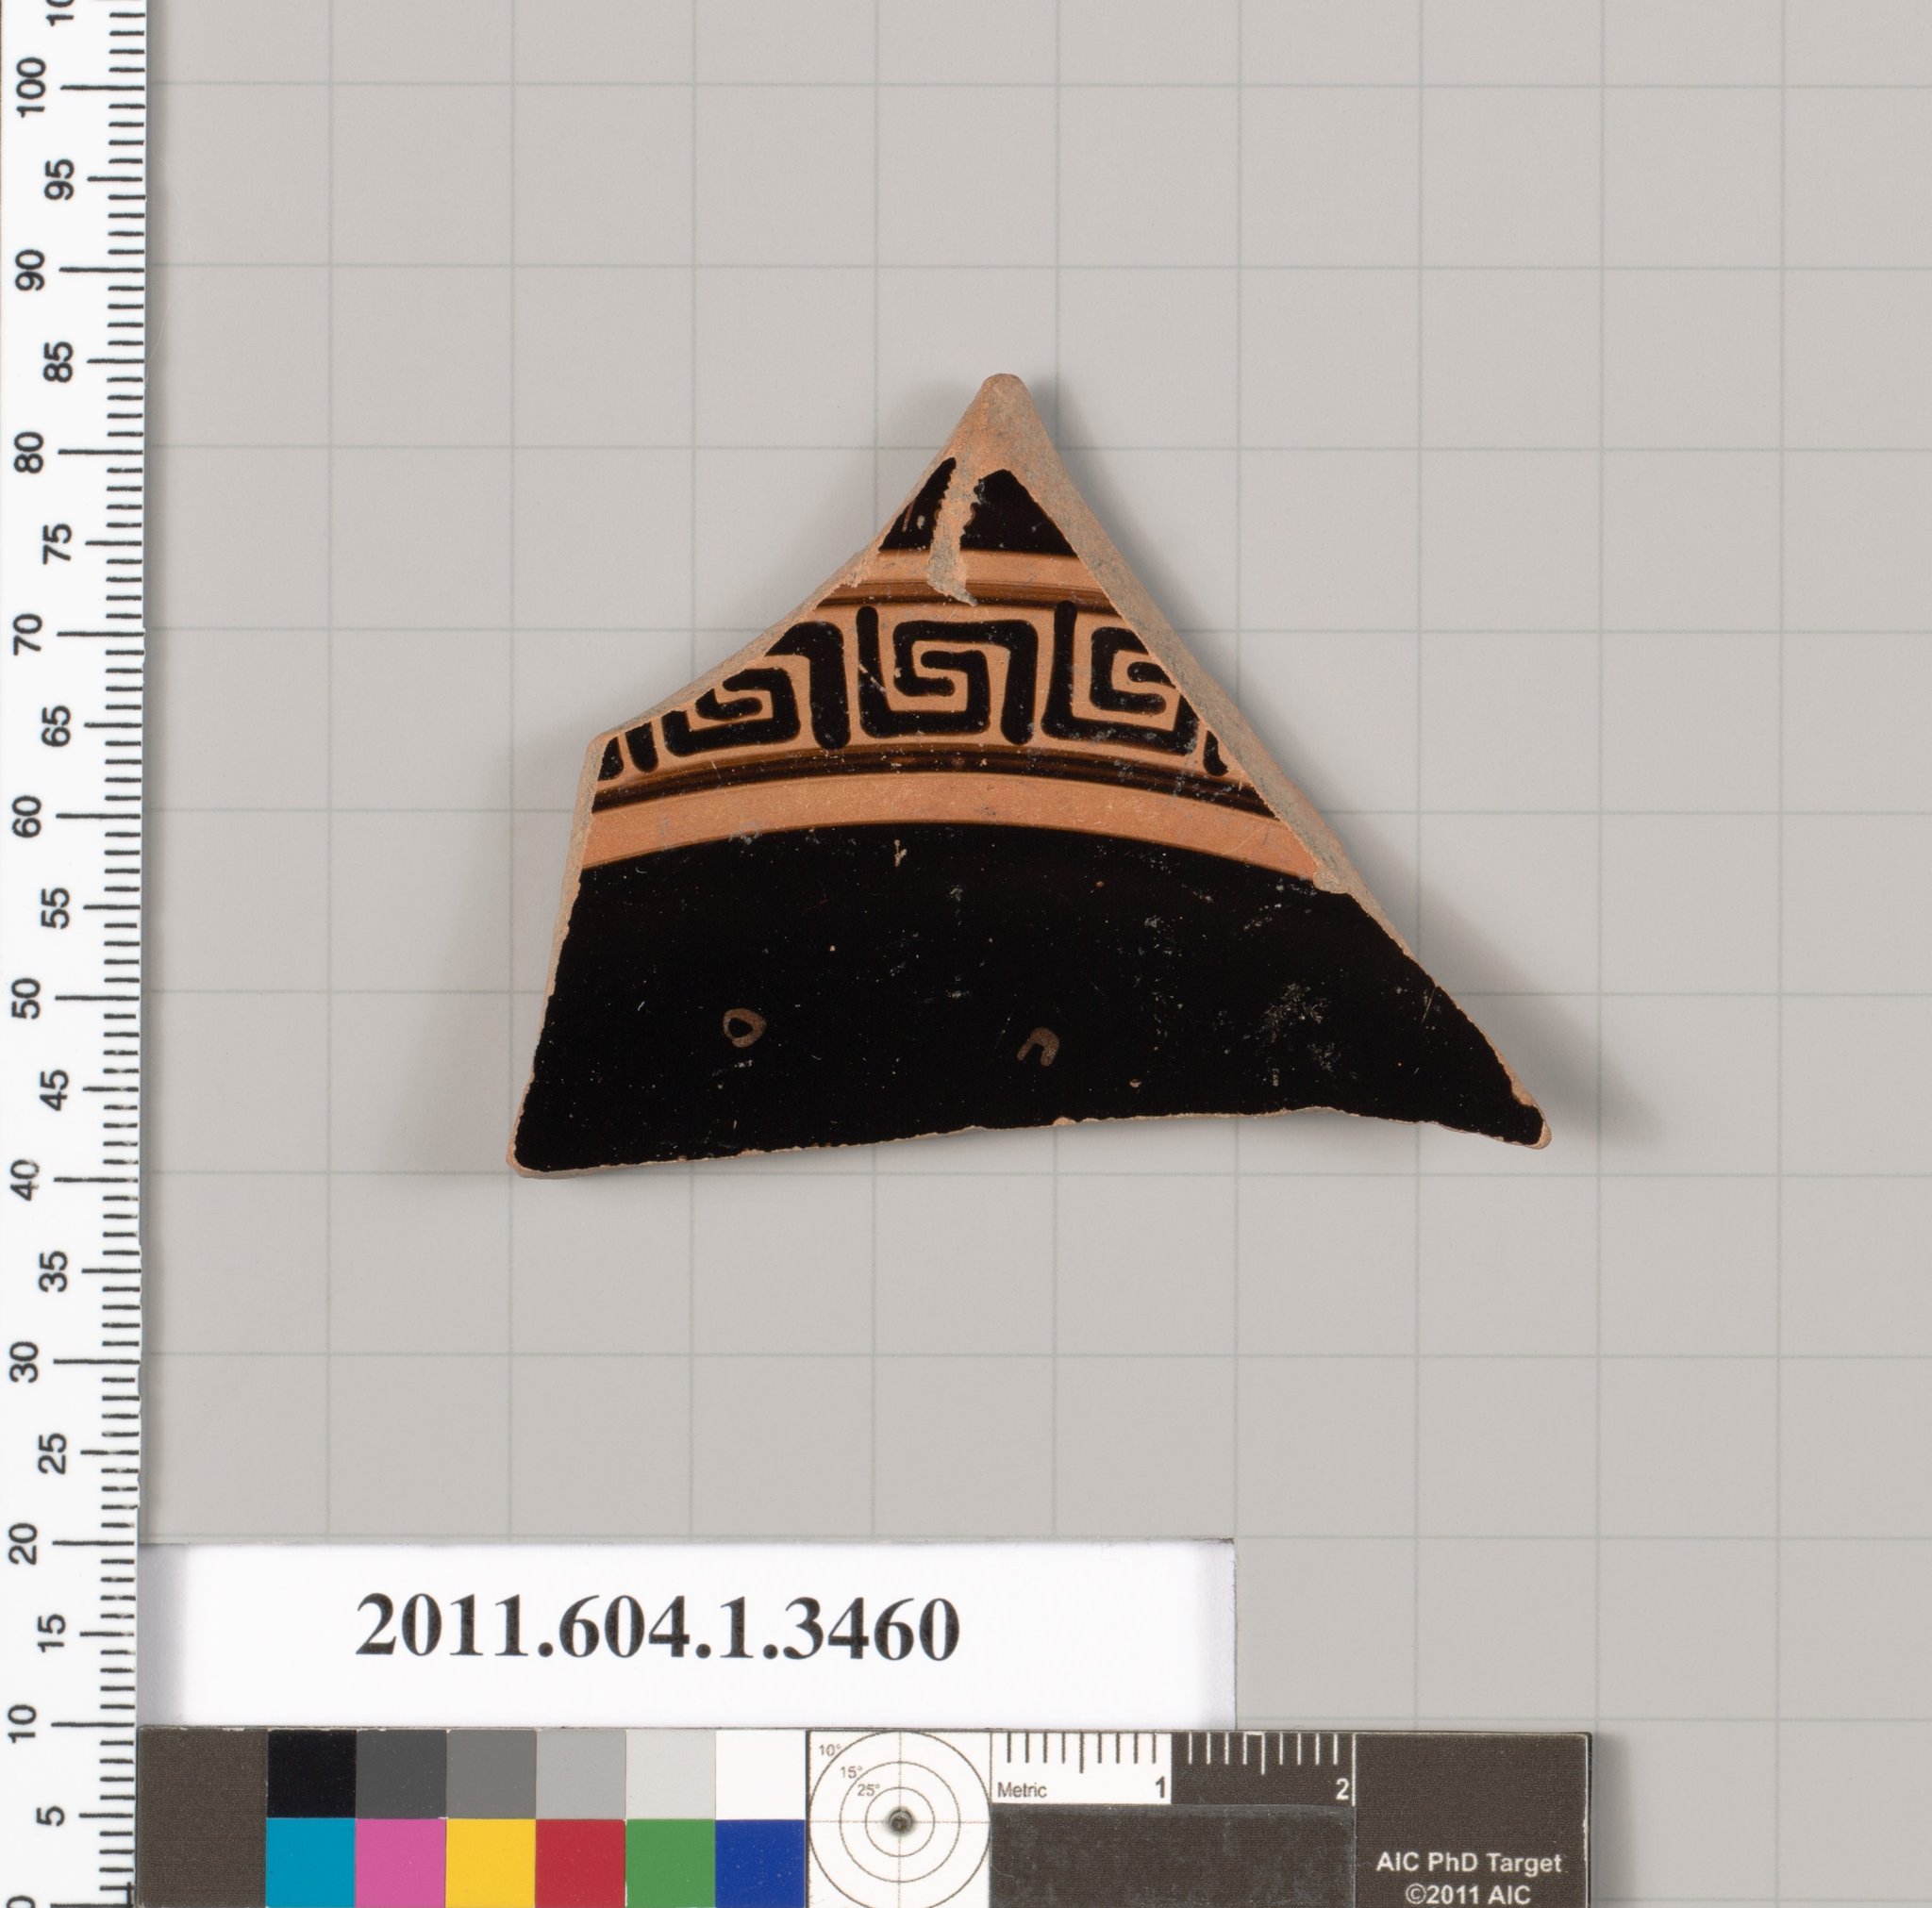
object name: kylix fragment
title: Terracotta fragment of a kylix (drinking cup)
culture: greek, attic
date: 500-476 BCE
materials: terracotta